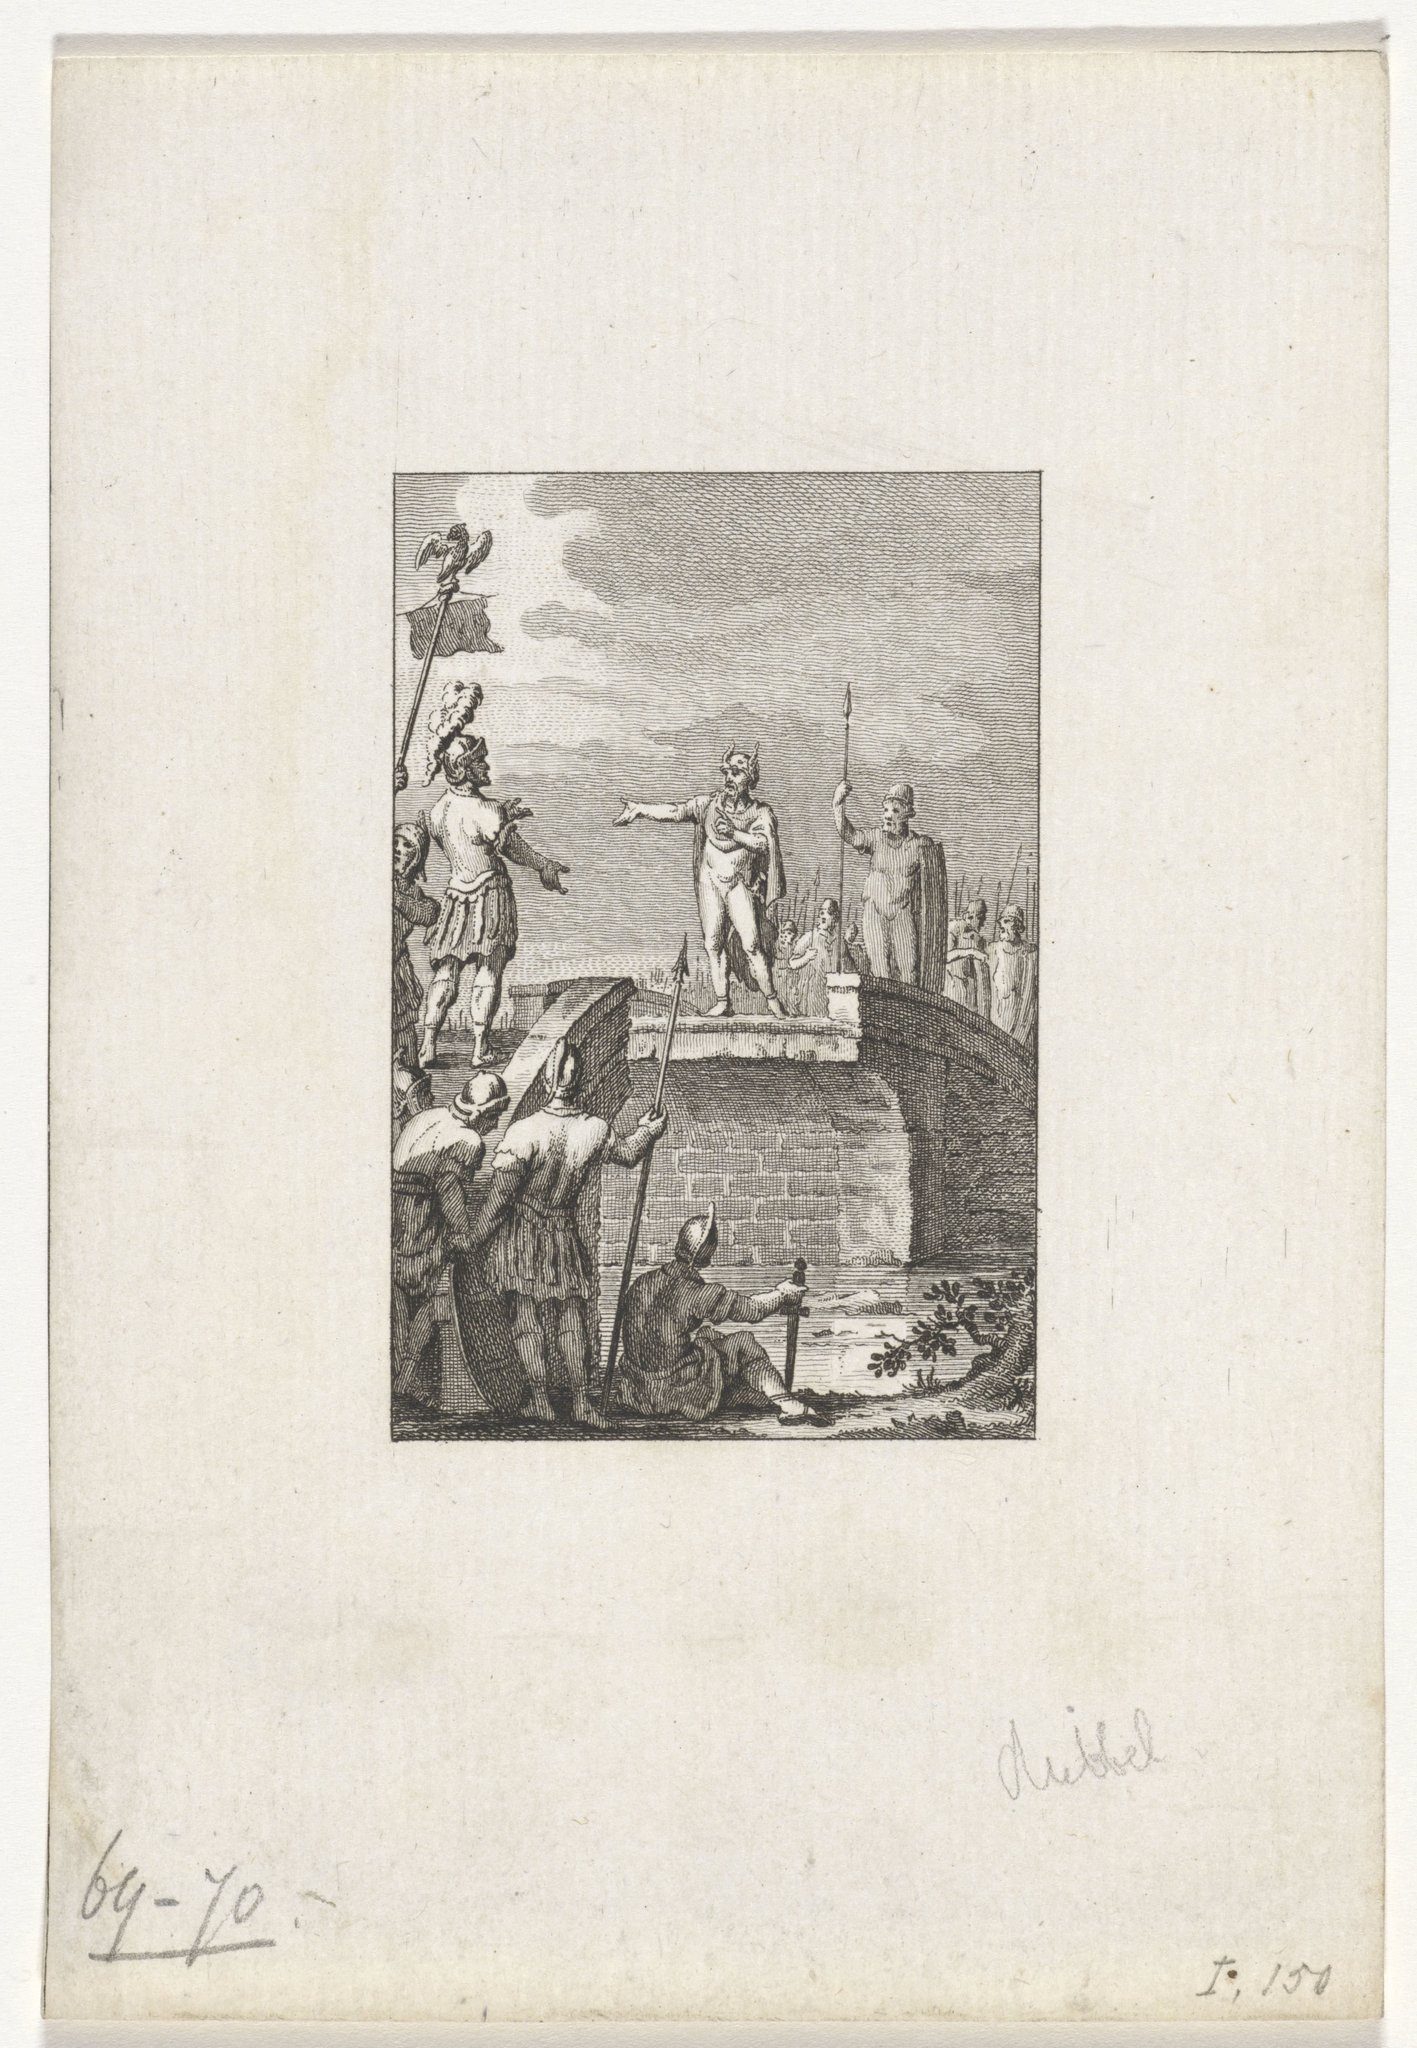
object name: print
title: Civilis en Cerialis onderhandelen op de afgebroken brug, 70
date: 1783-1795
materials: paper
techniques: etching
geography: amsterdam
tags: peace negotiations, extinct, 'historical' peoples (with name)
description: Illustratie voor: J. Fokke. Geschiedenissen der Vereenigde Nederlanden voor de vaderlandsche jeugd. Amsterdam: Johannes Allart, 1783-1795, 25 delen, dl. I, pl. VI.